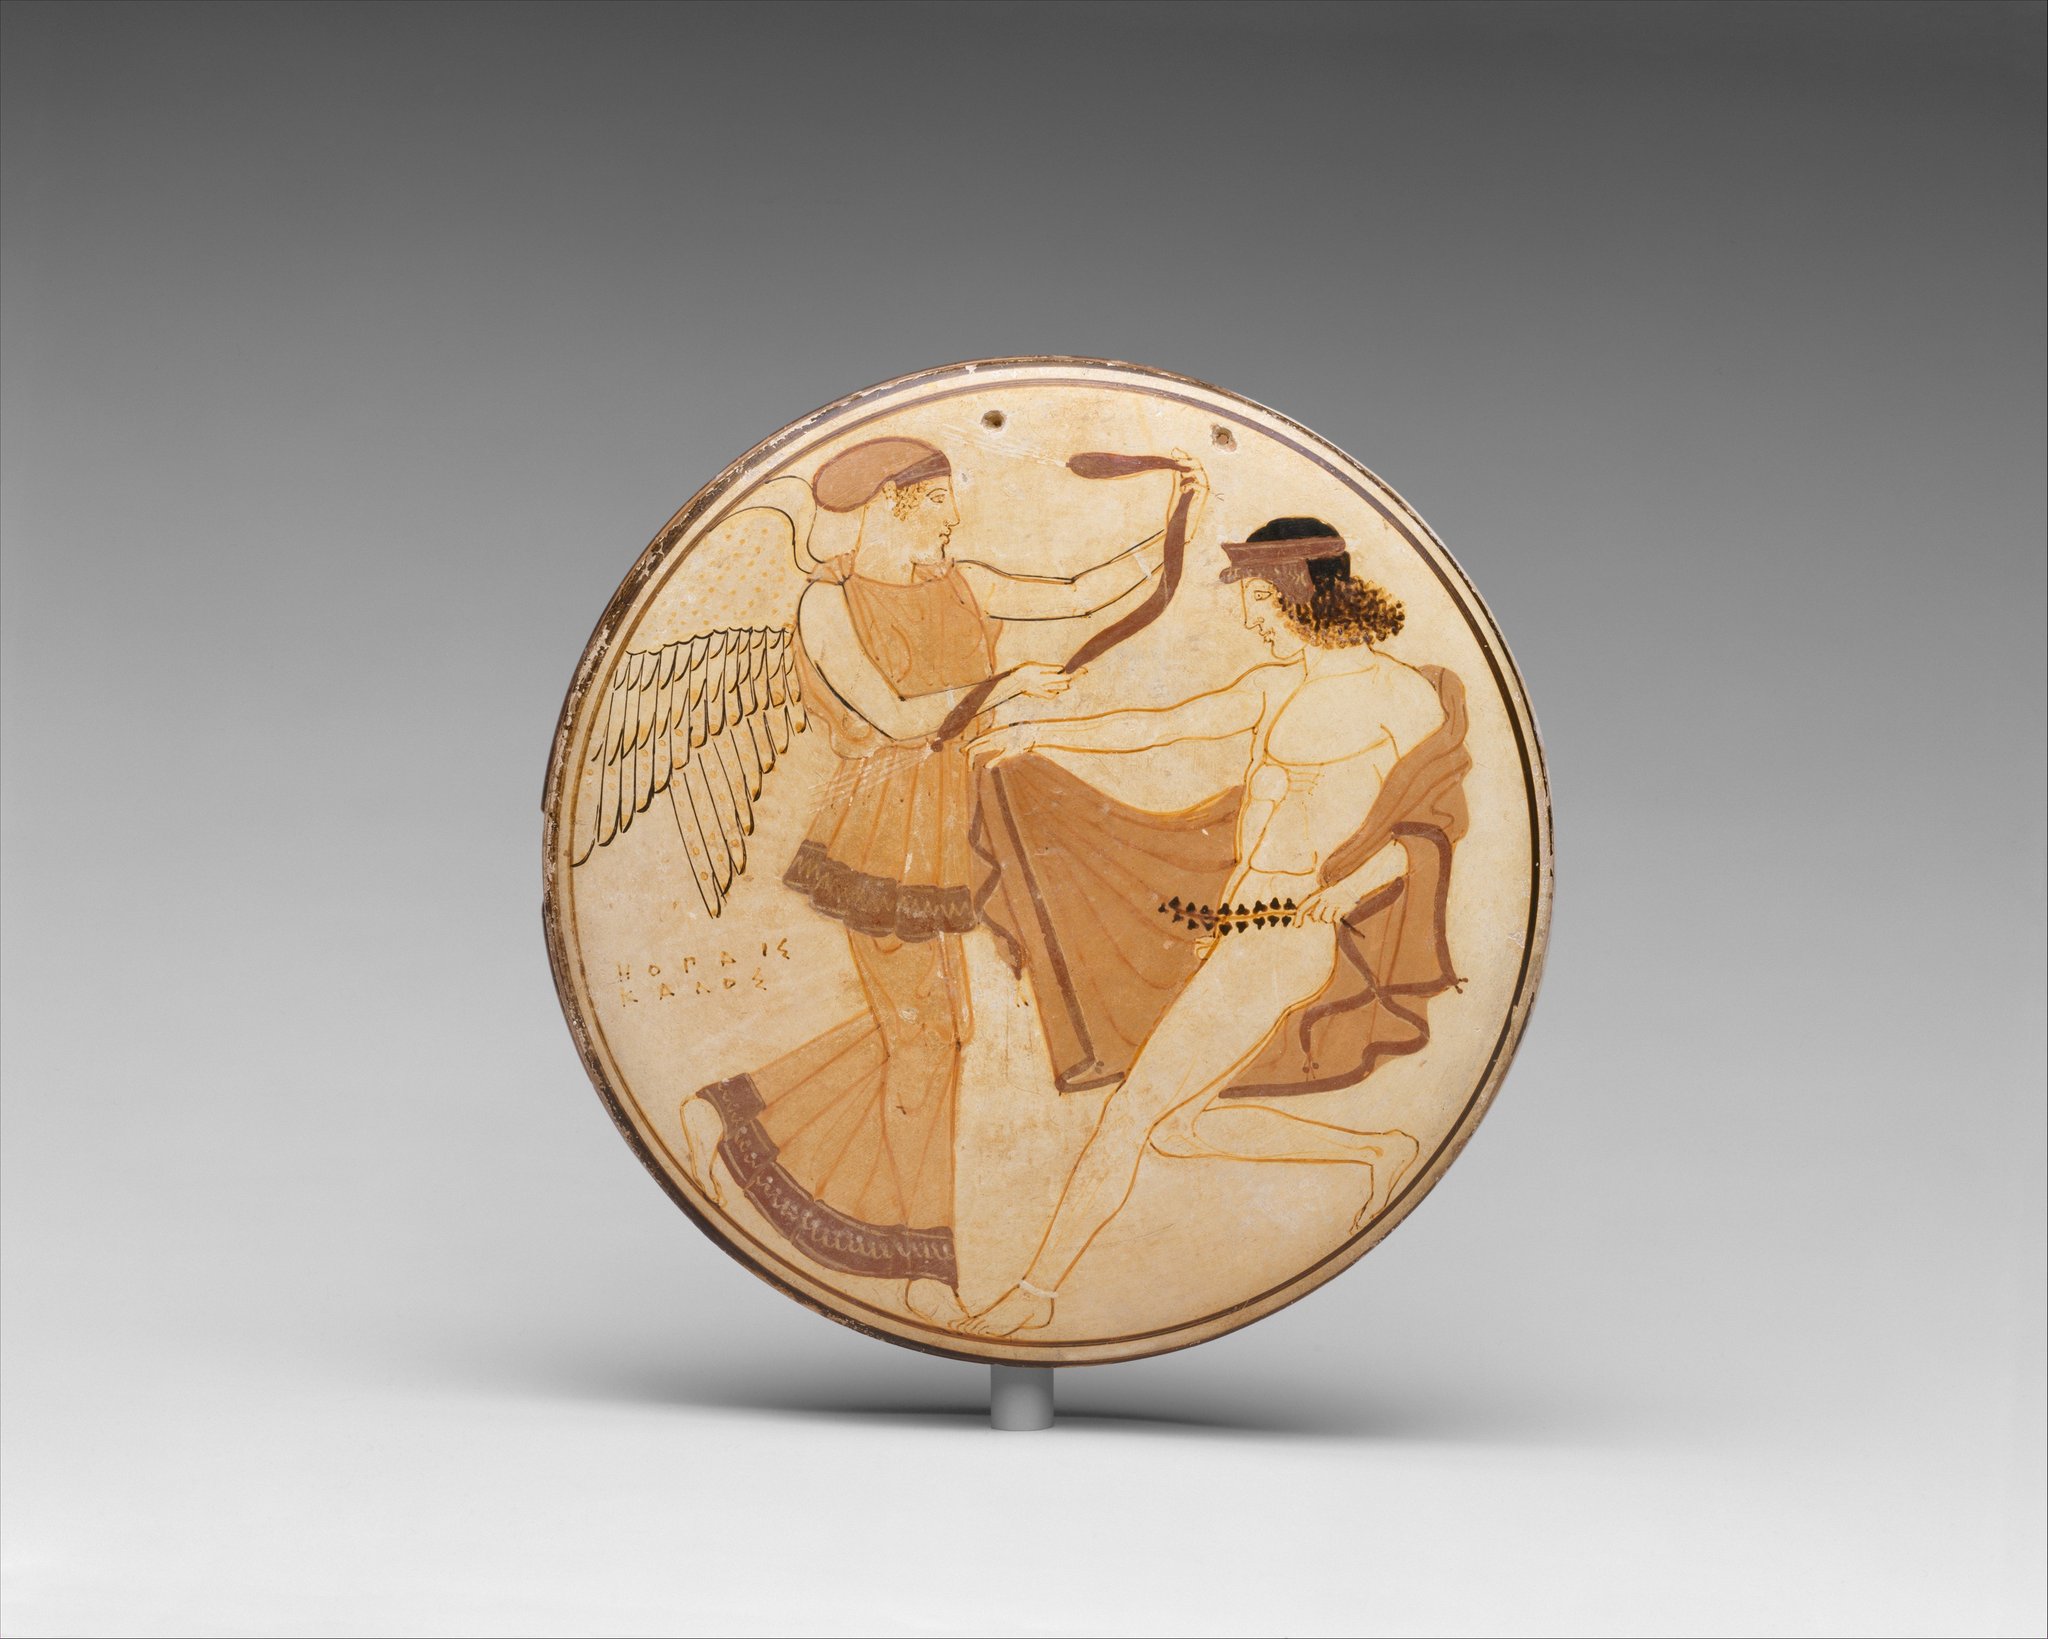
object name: bobbin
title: Terracotta bobbin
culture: greek, attic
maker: penthesilea painter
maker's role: artist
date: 460-450 BCE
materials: terracotta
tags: eros,nike